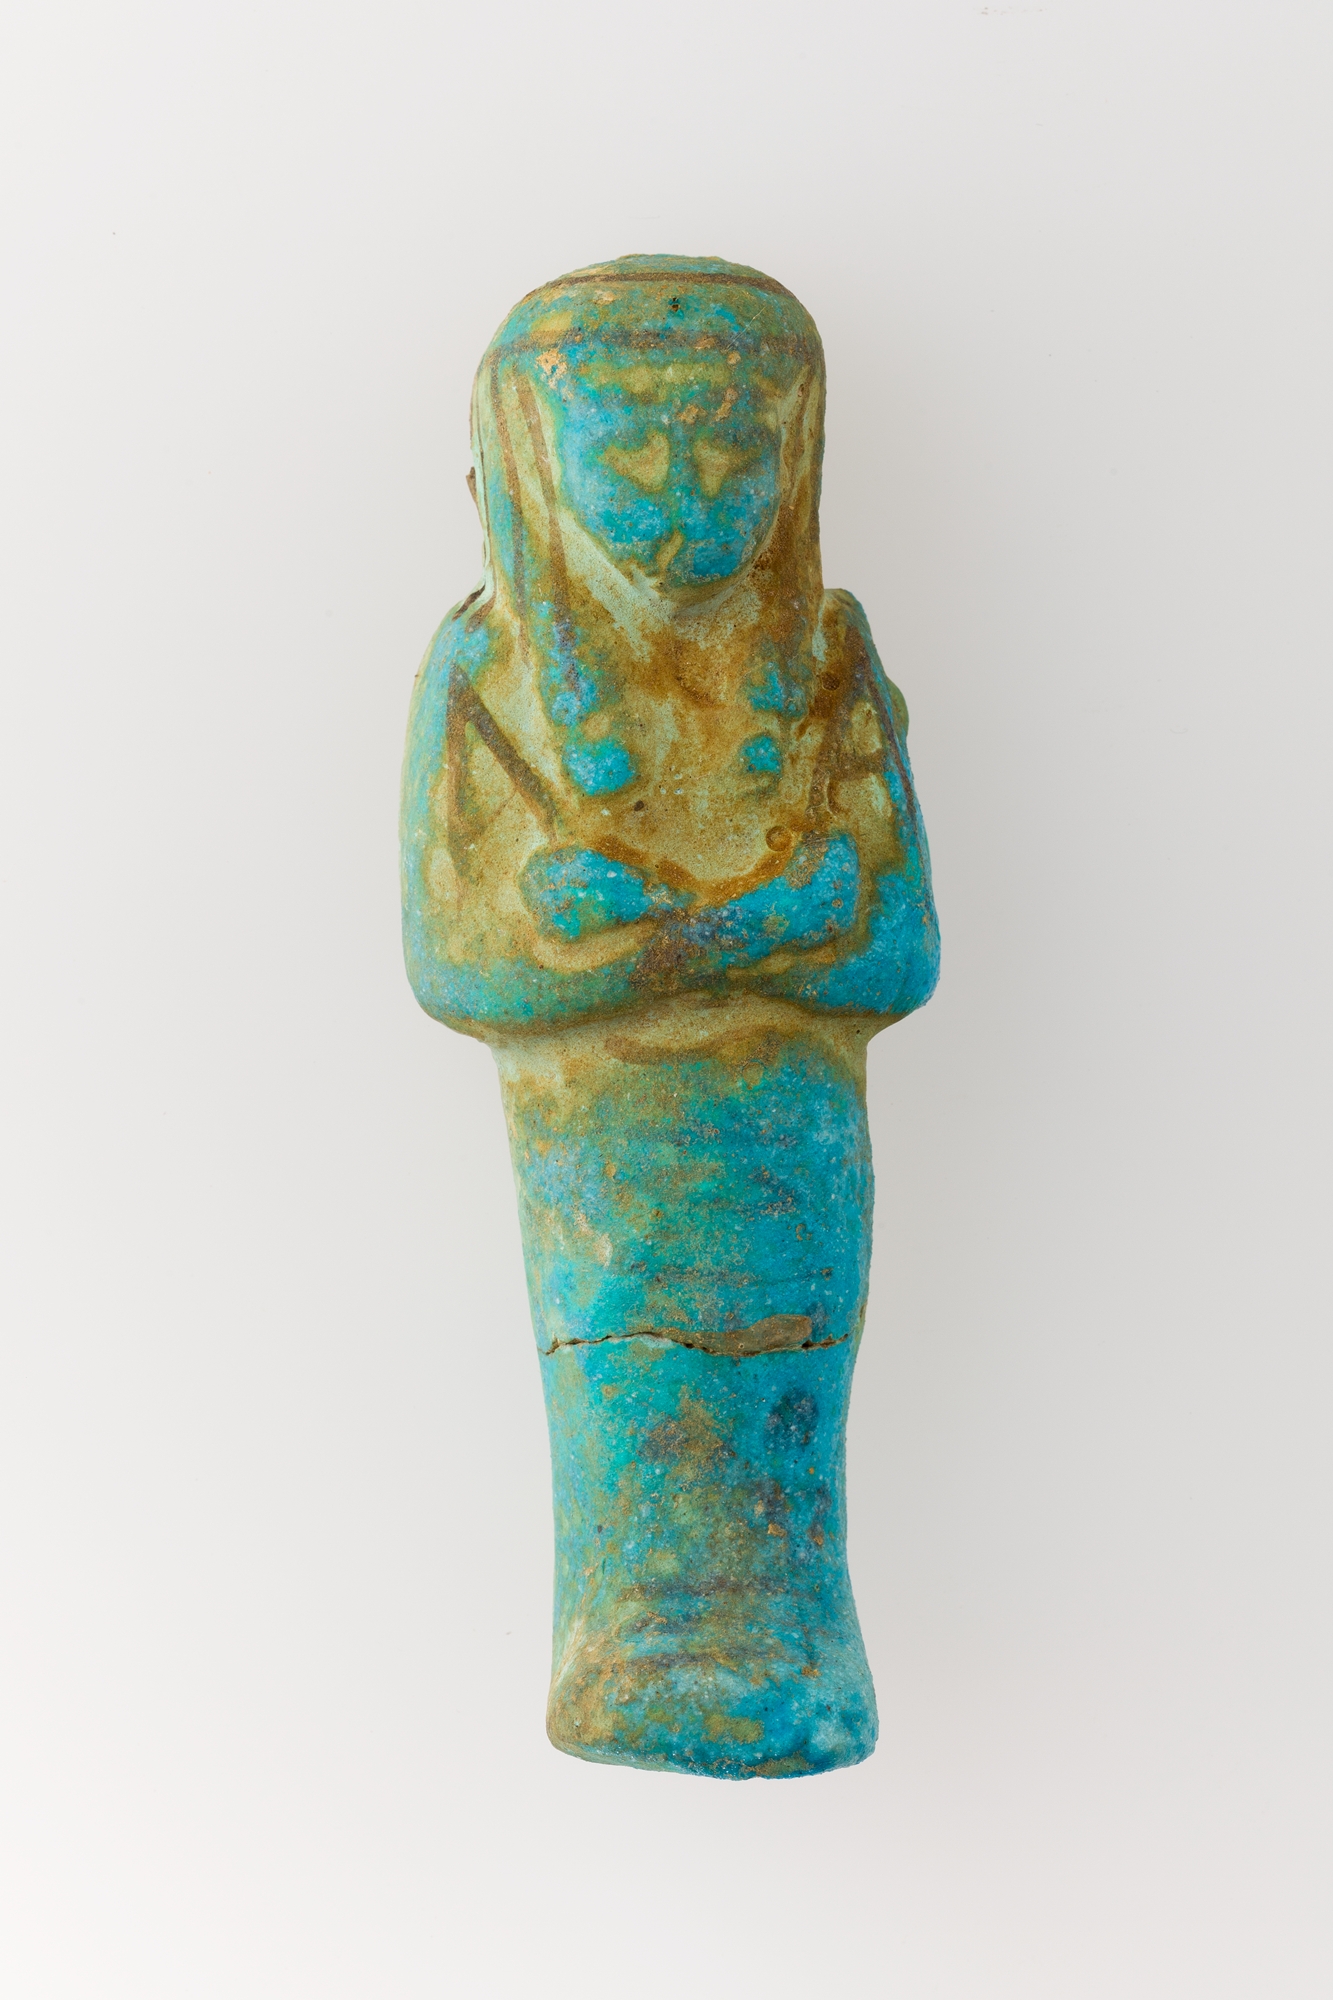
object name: shabti, henettawy c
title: Worker Shabti of Henettawy (C), Daughter of Isetemkheb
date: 990-970 BCE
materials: faience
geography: egypt